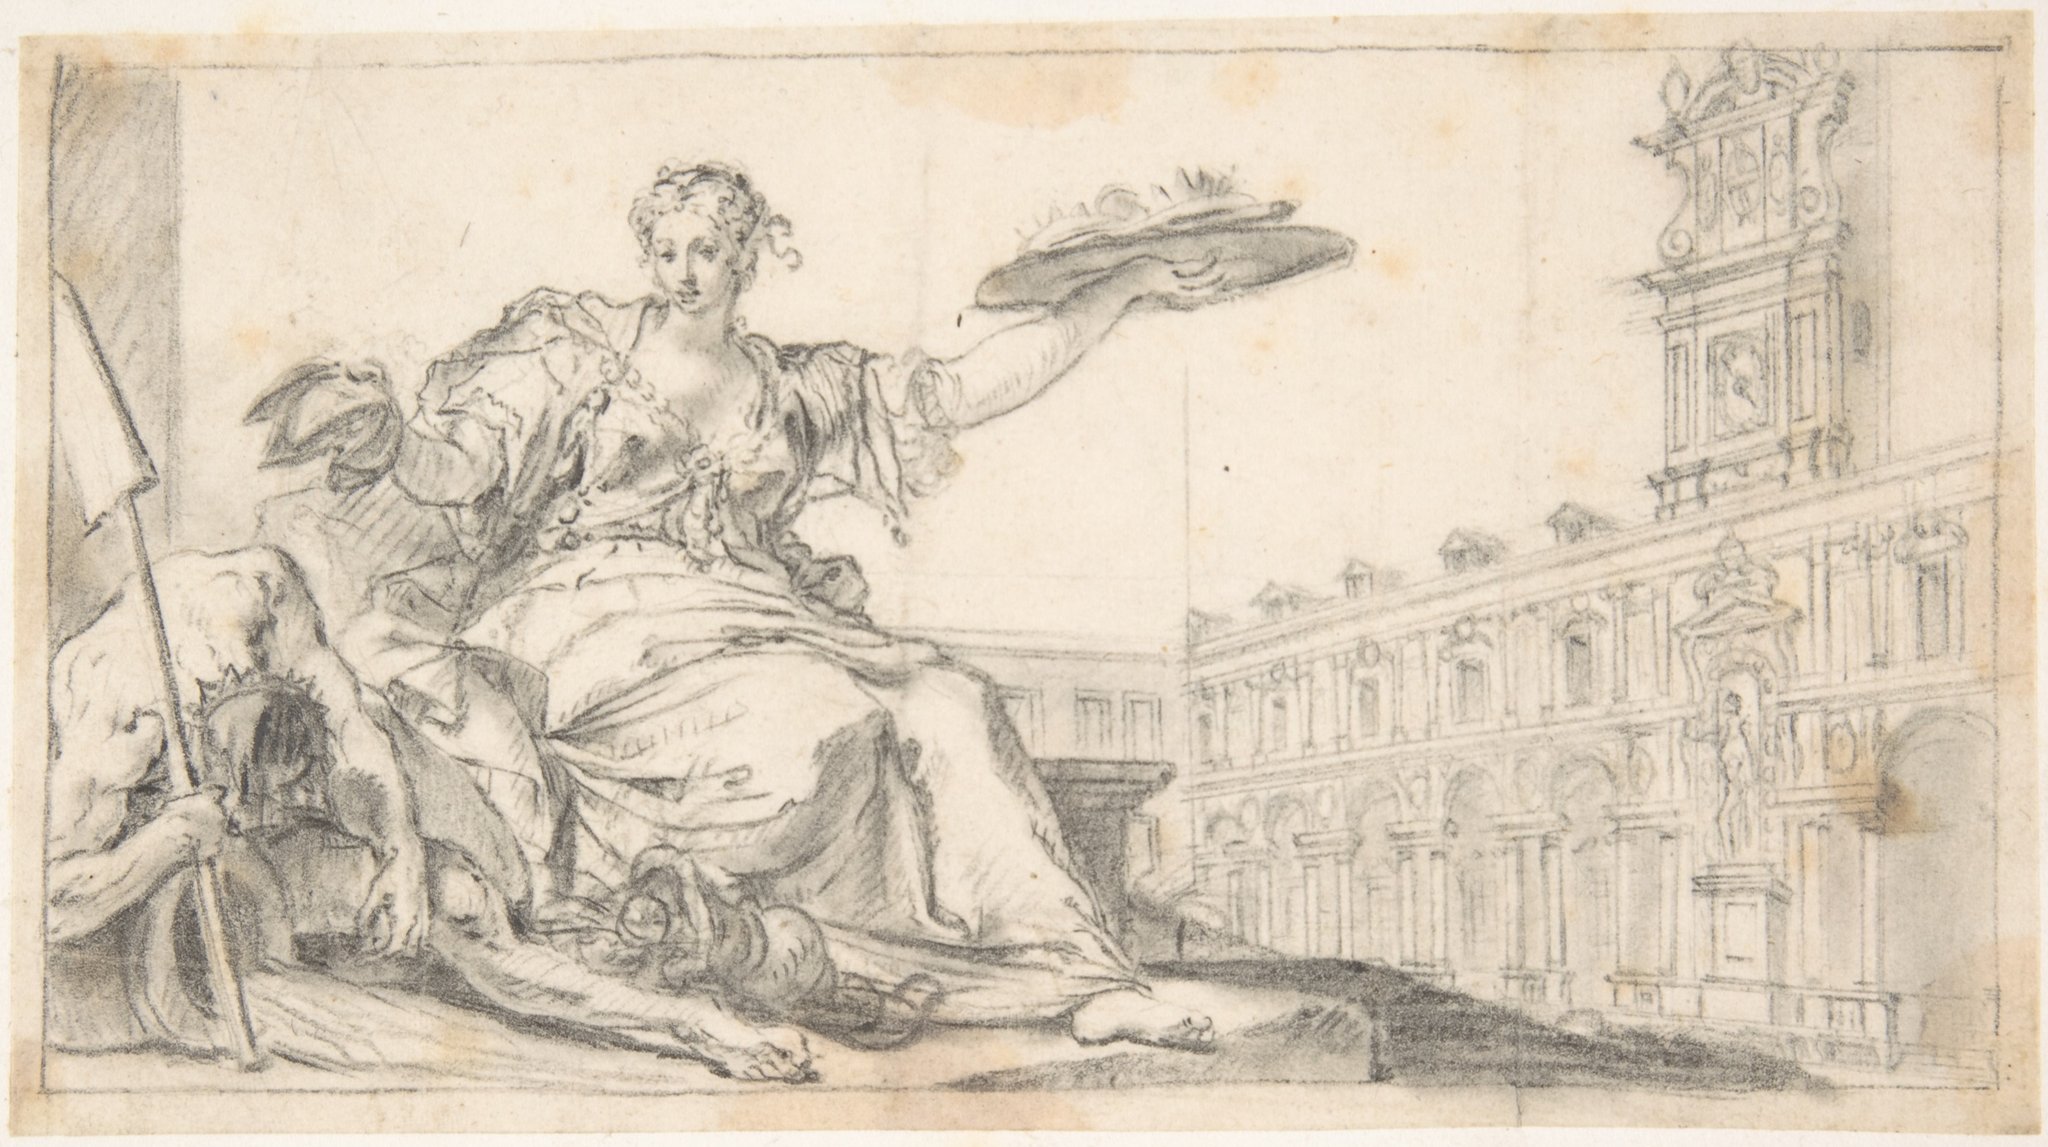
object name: drawing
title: Allegory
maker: anonymous, italian, venetian, 18th century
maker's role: artist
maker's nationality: italian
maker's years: 1700-1800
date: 1701-1800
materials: chalk, charcoal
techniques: wash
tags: men,women